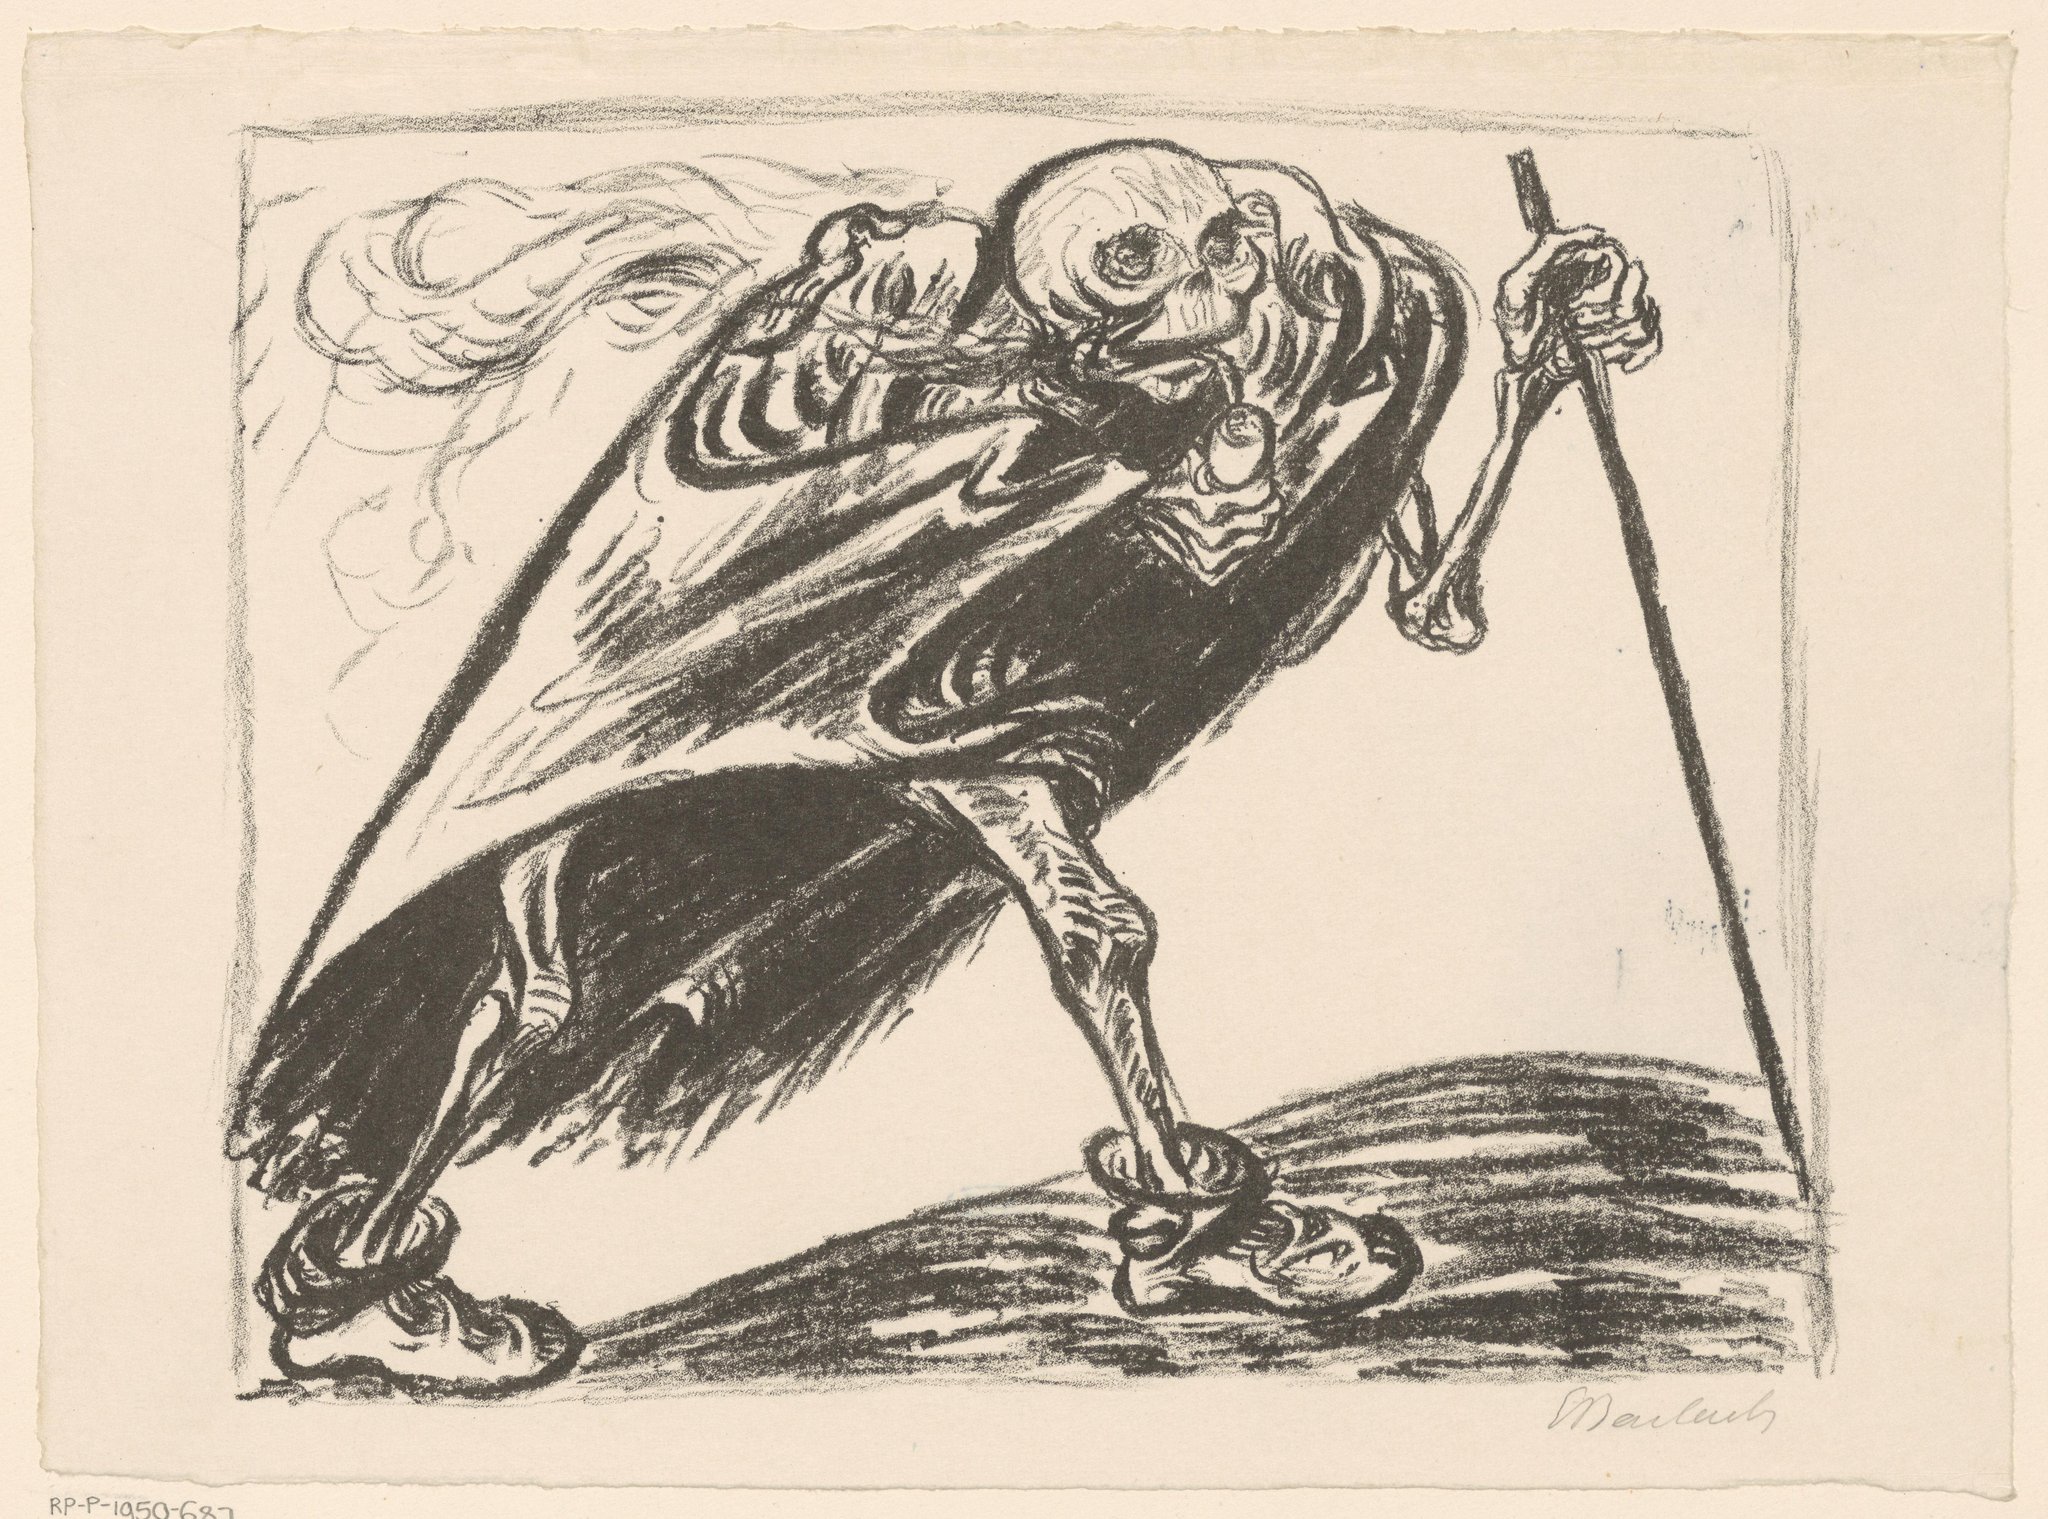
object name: print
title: Magere Hein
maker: ernst barlach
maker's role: print maker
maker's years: 1870-1938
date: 1880-1938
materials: paper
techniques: lithograph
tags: death as skeleton, pipe ~ tobacco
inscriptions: collector's mark: Lugt 2228